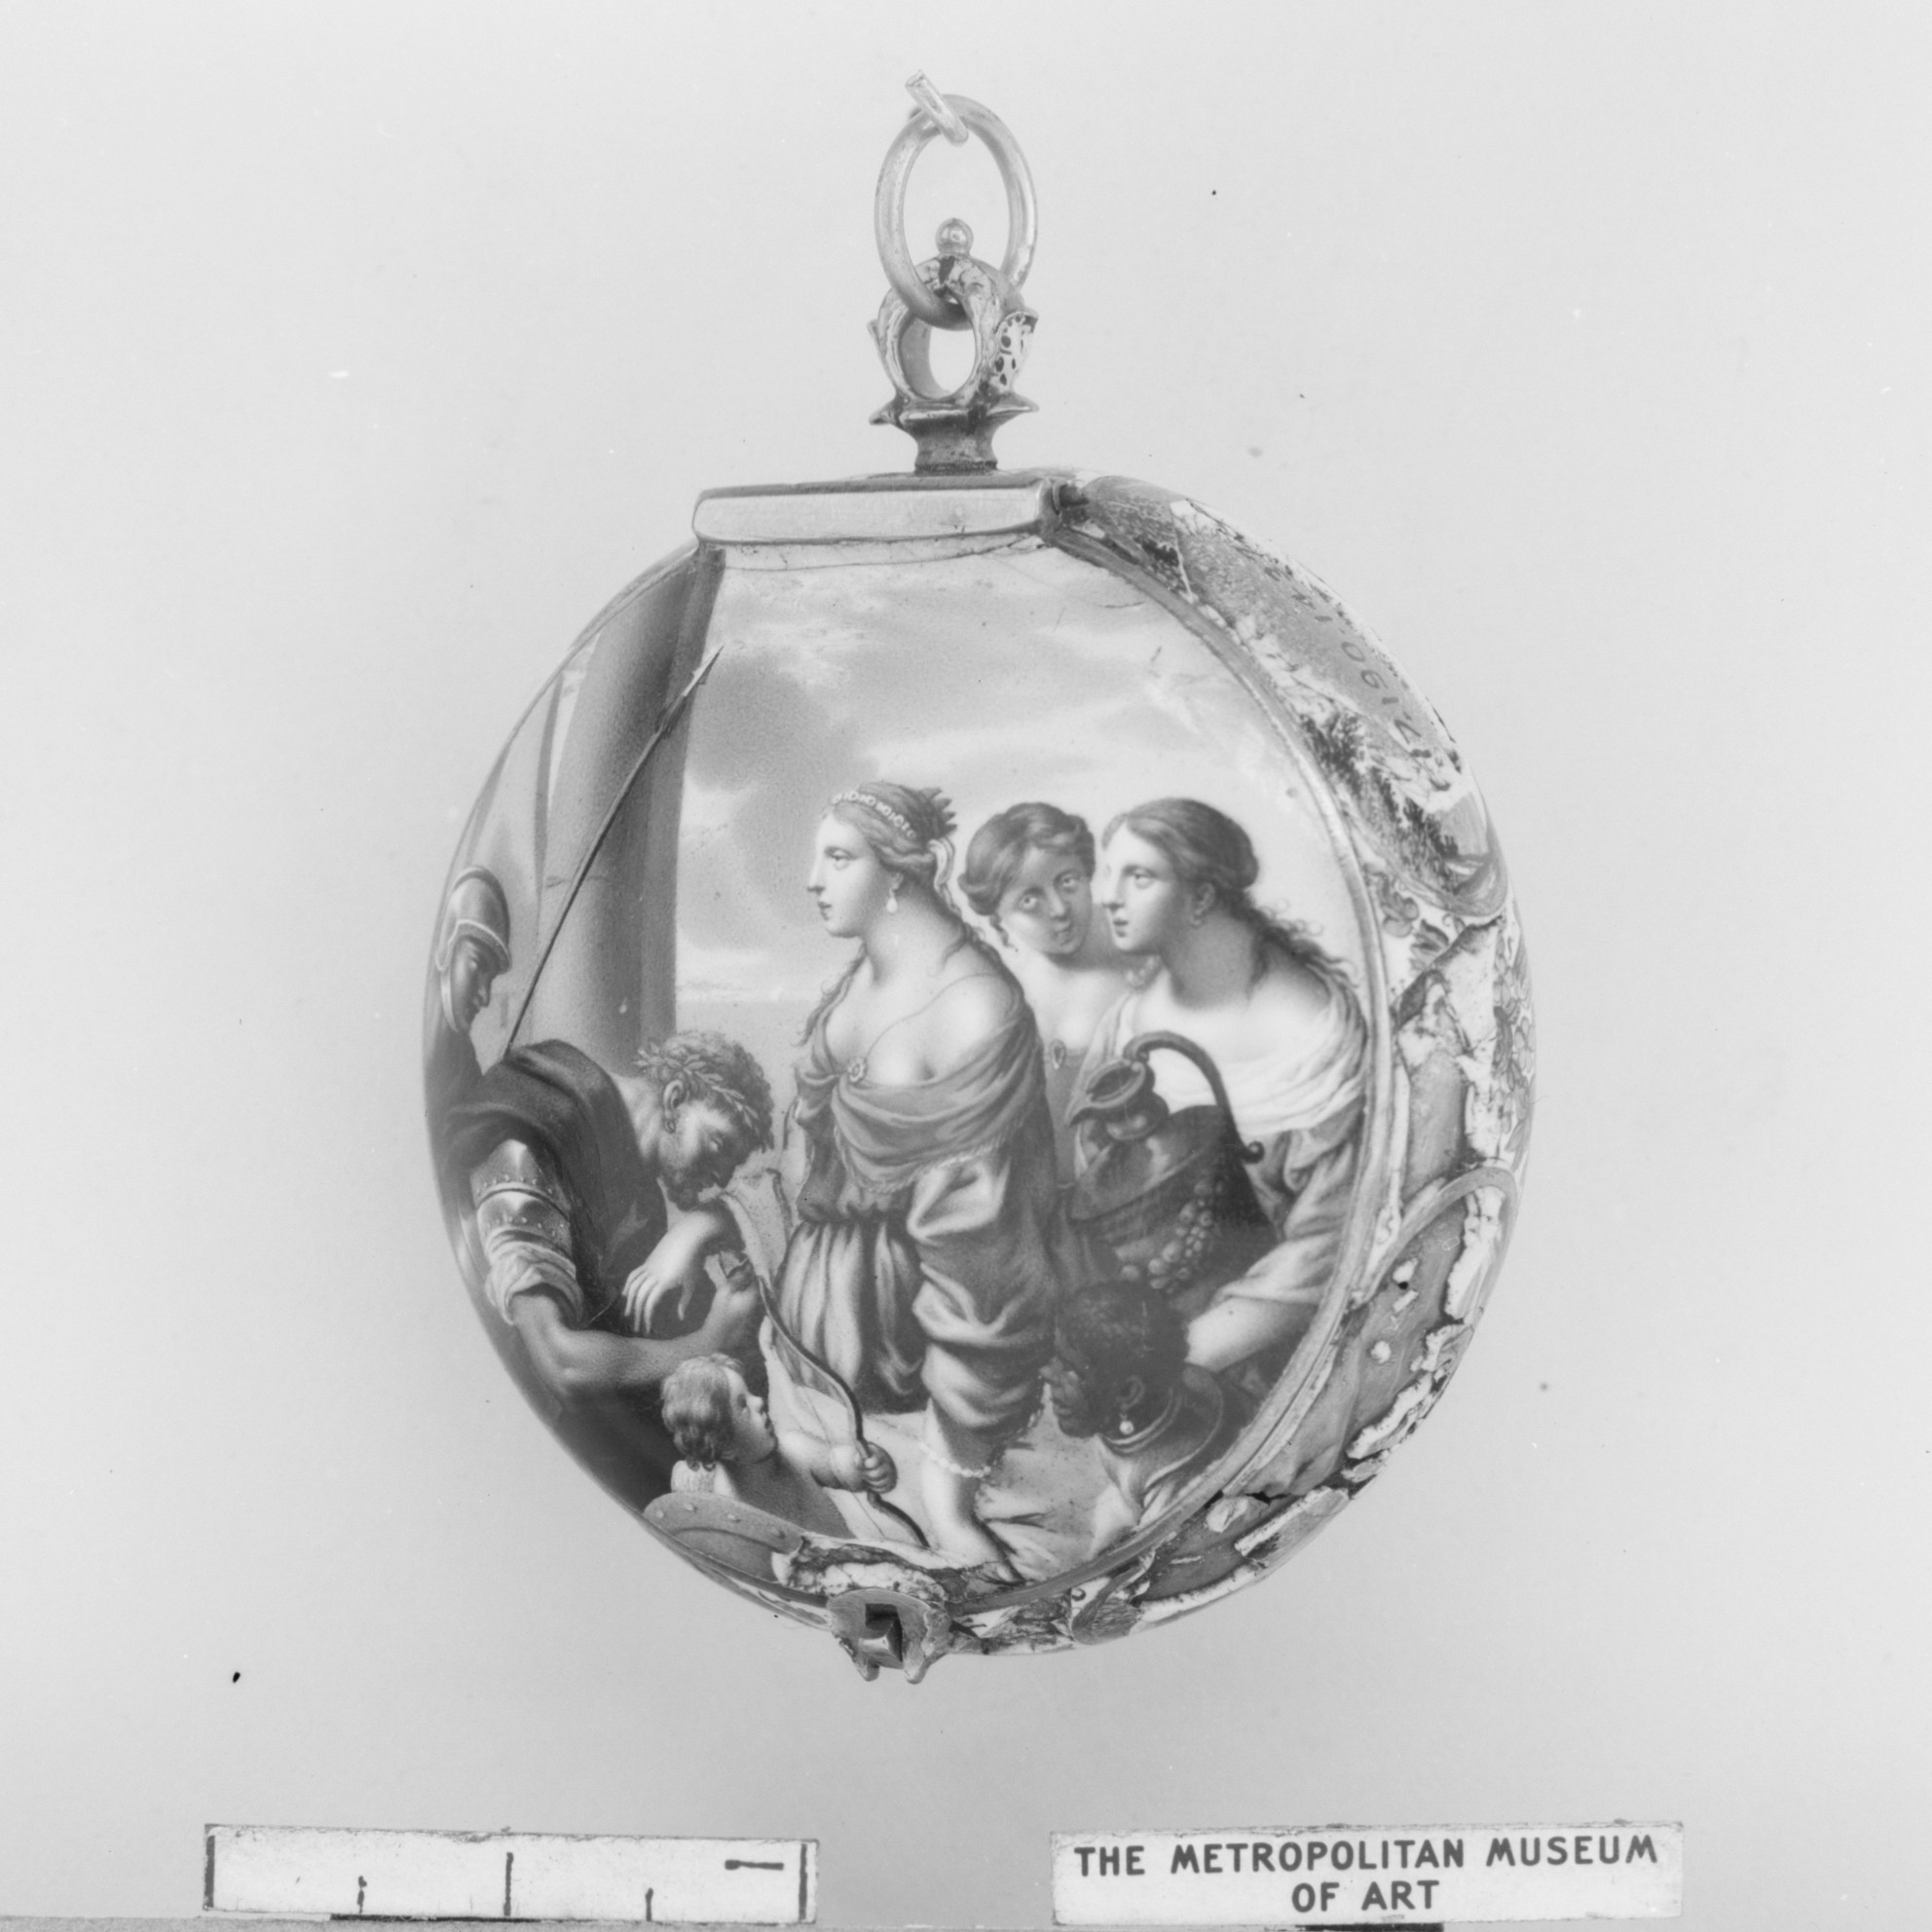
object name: watch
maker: pierre landré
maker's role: maker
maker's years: 1635-1665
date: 1630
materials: enamel, metal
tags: bow and arrow,men,women